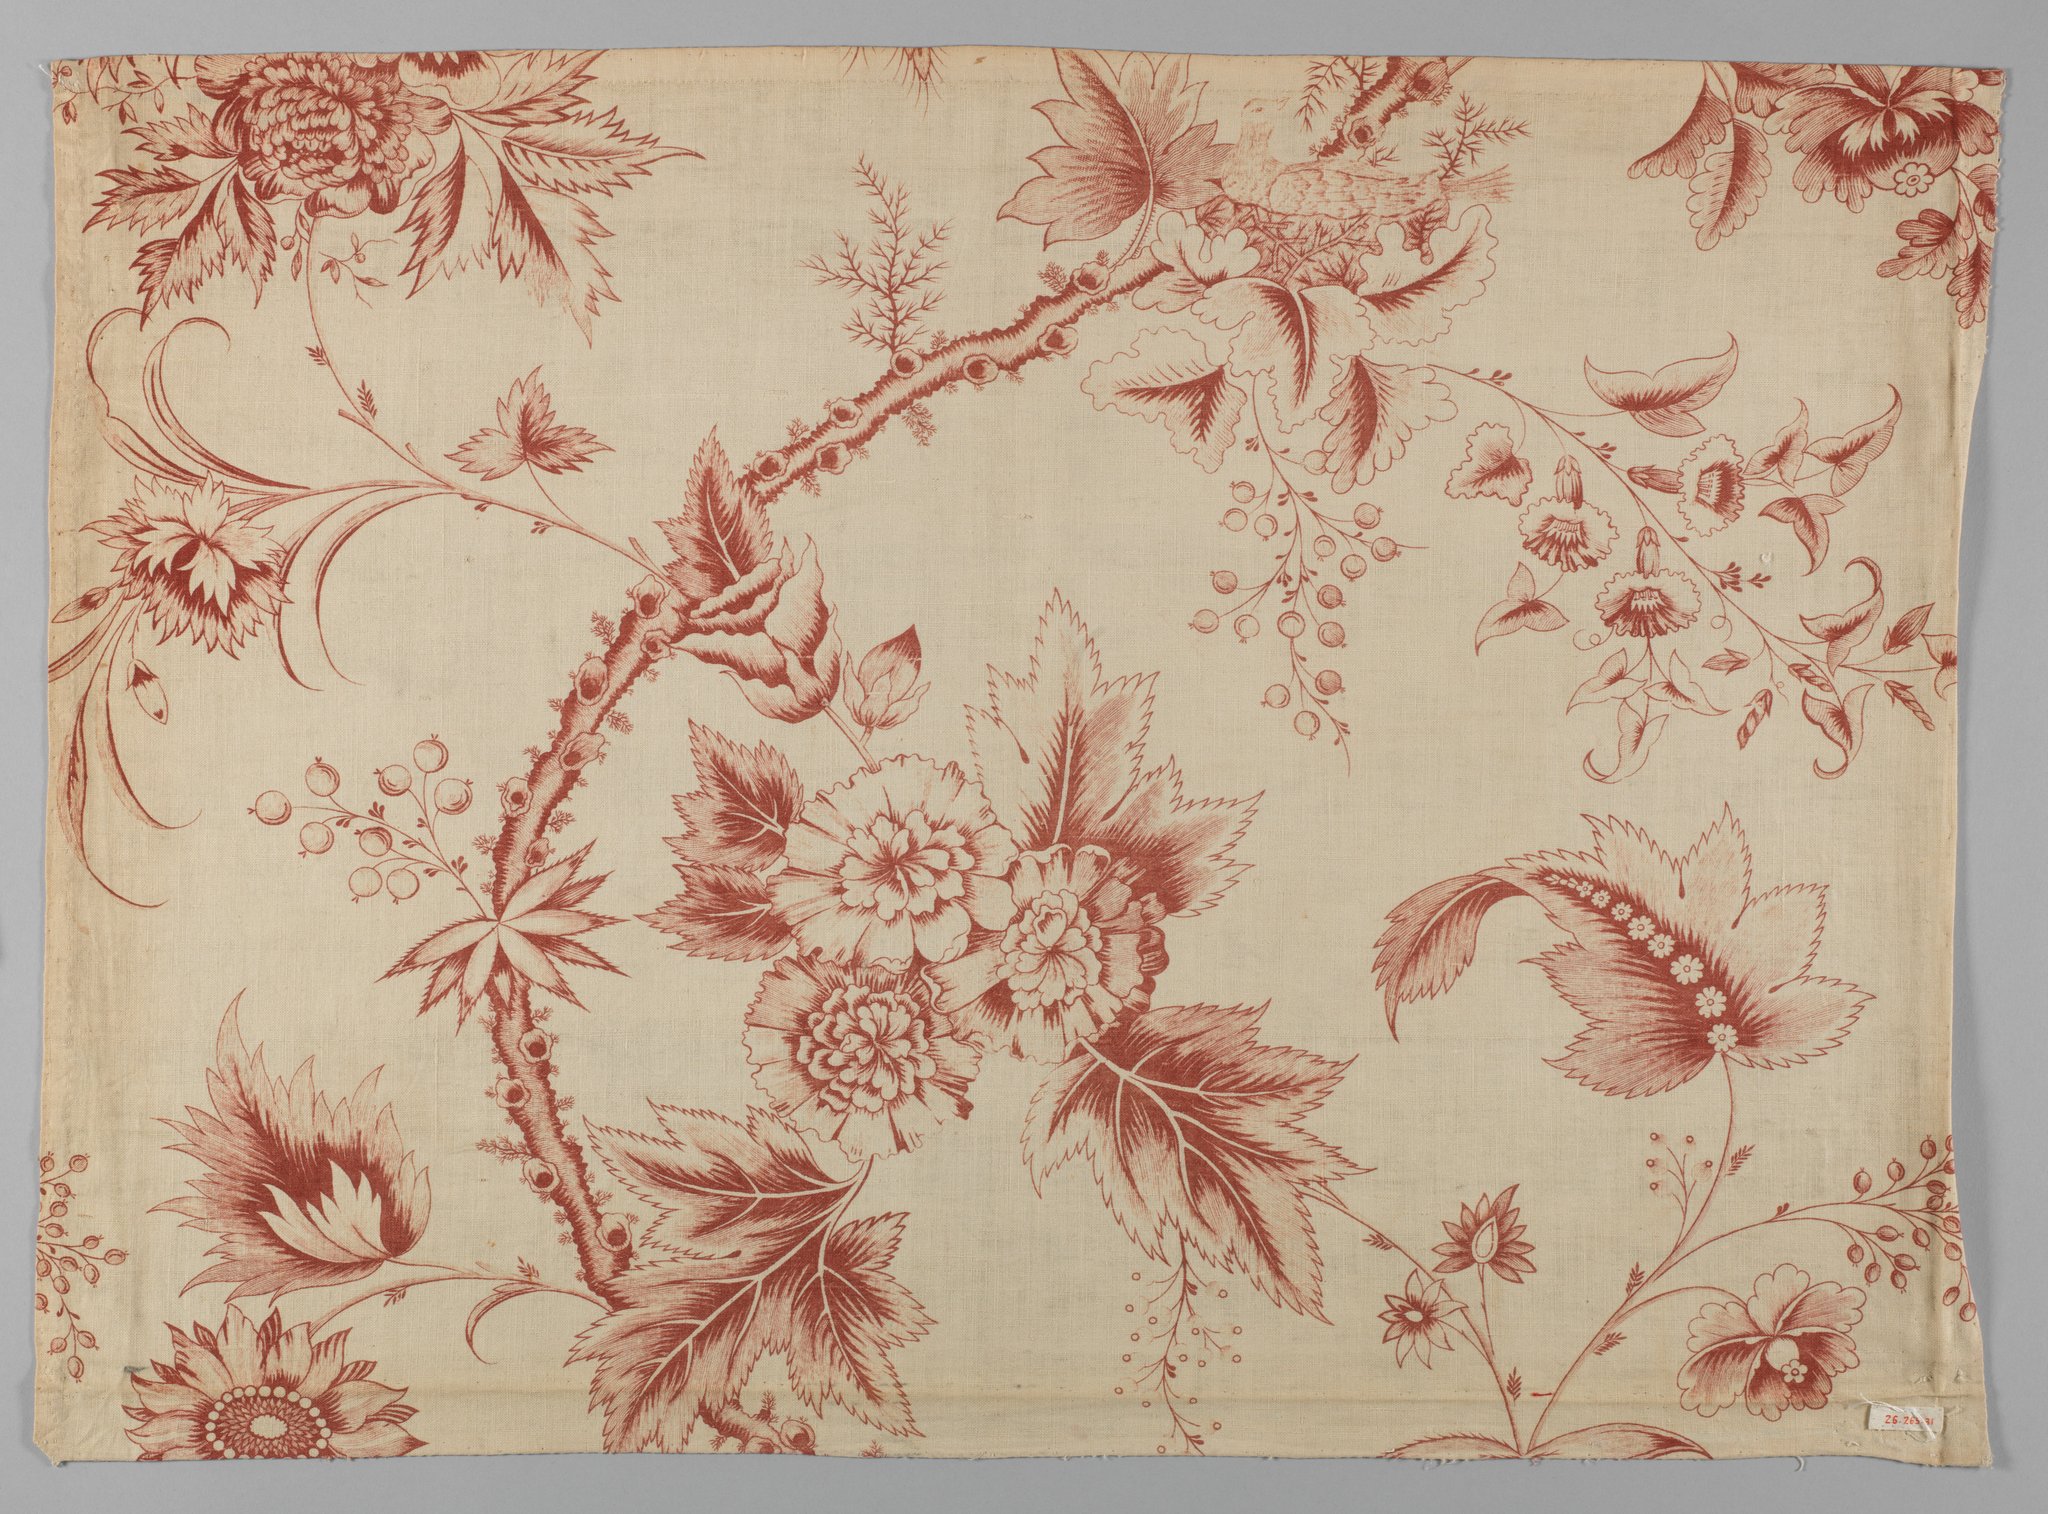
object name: piece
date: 1805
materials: cotton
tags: flowers